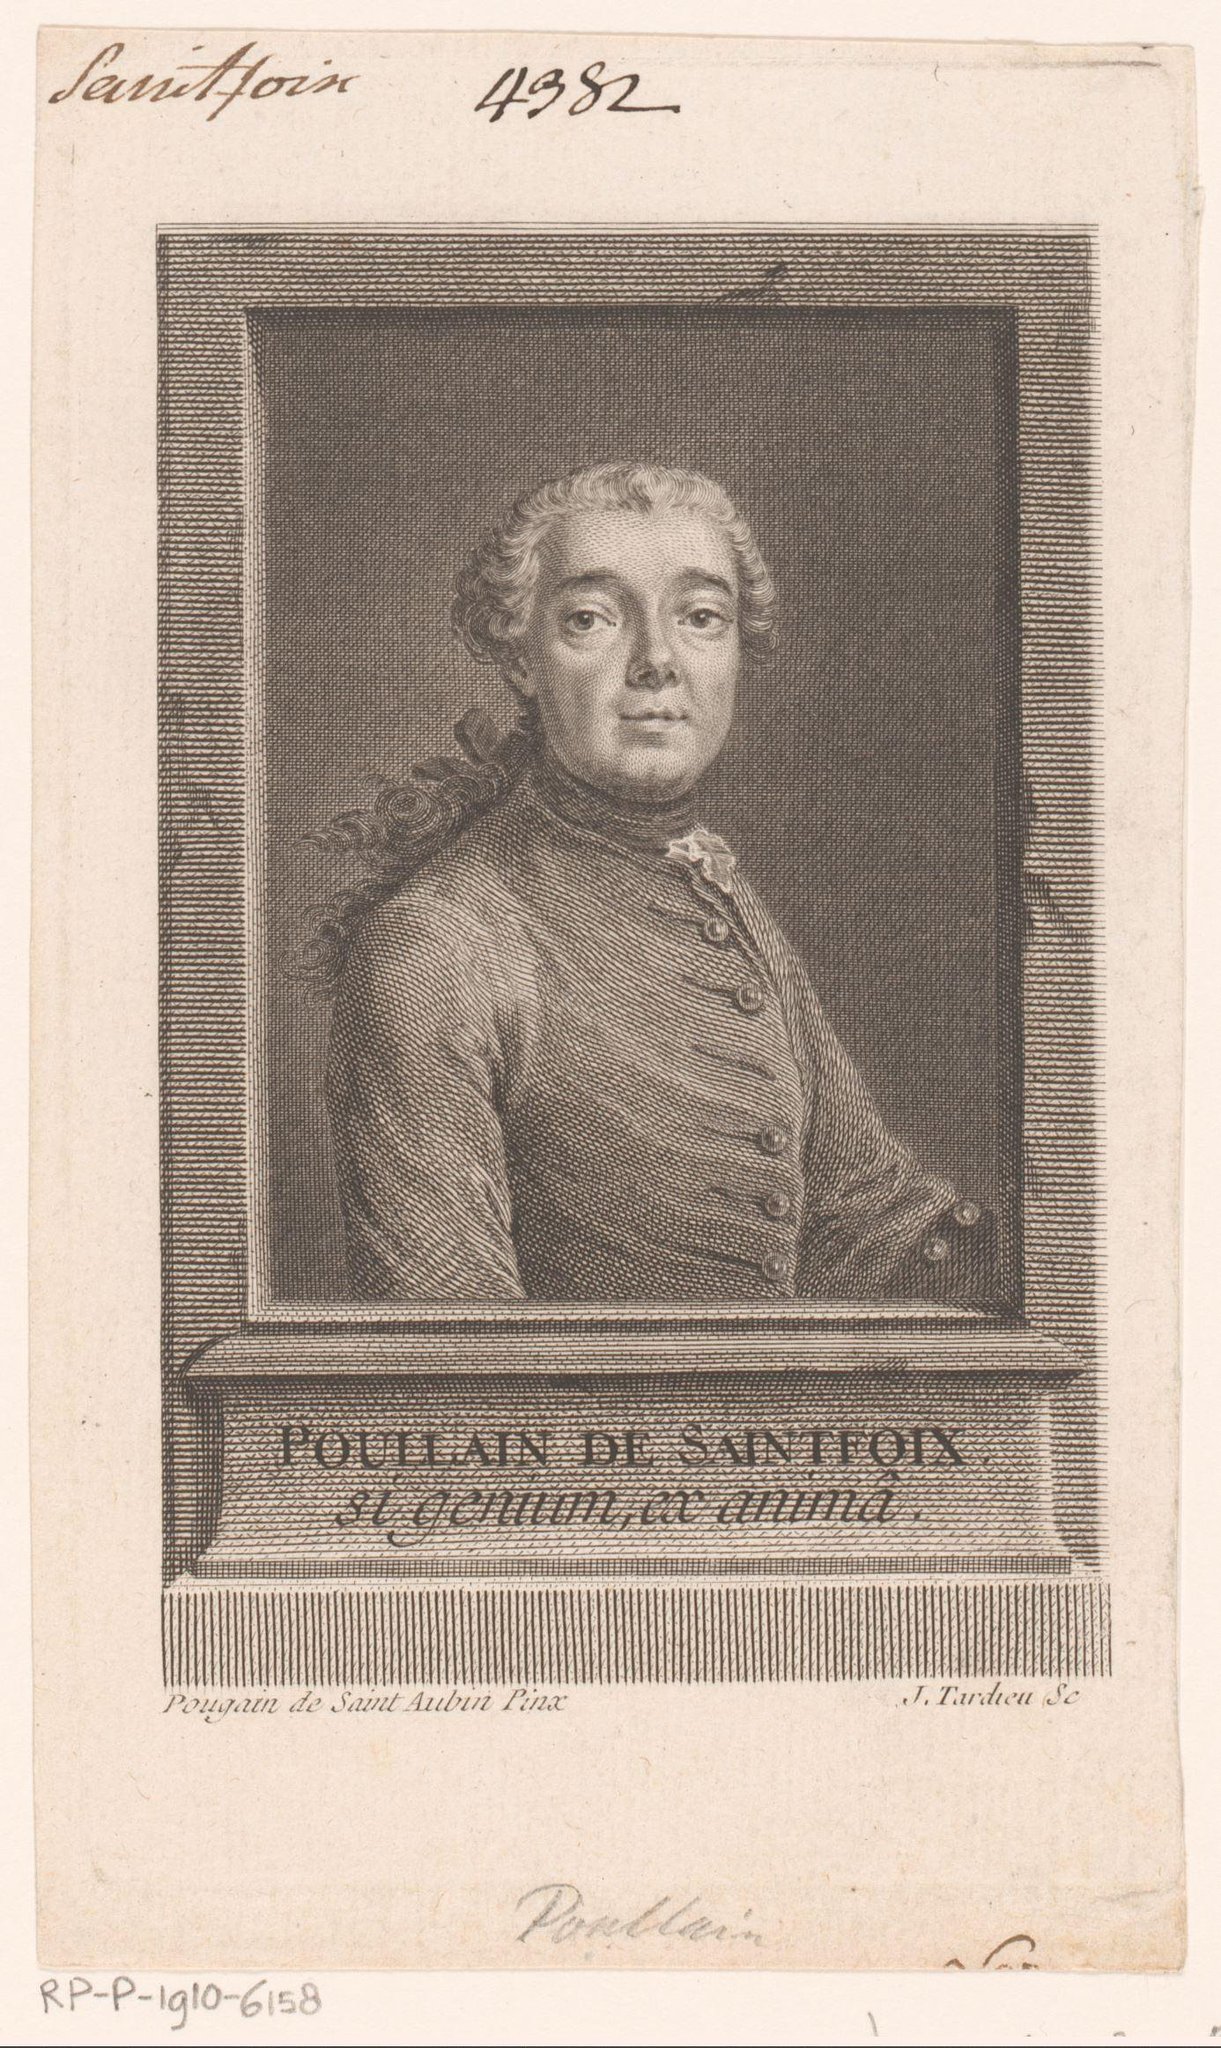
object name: print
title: Portret van Germain-François Poullain de Saint-Foix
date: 1726-1783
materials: paper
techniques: engraving, etching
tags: historical persons, portrait of a writer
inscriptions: collector's mark: Lugt 2228